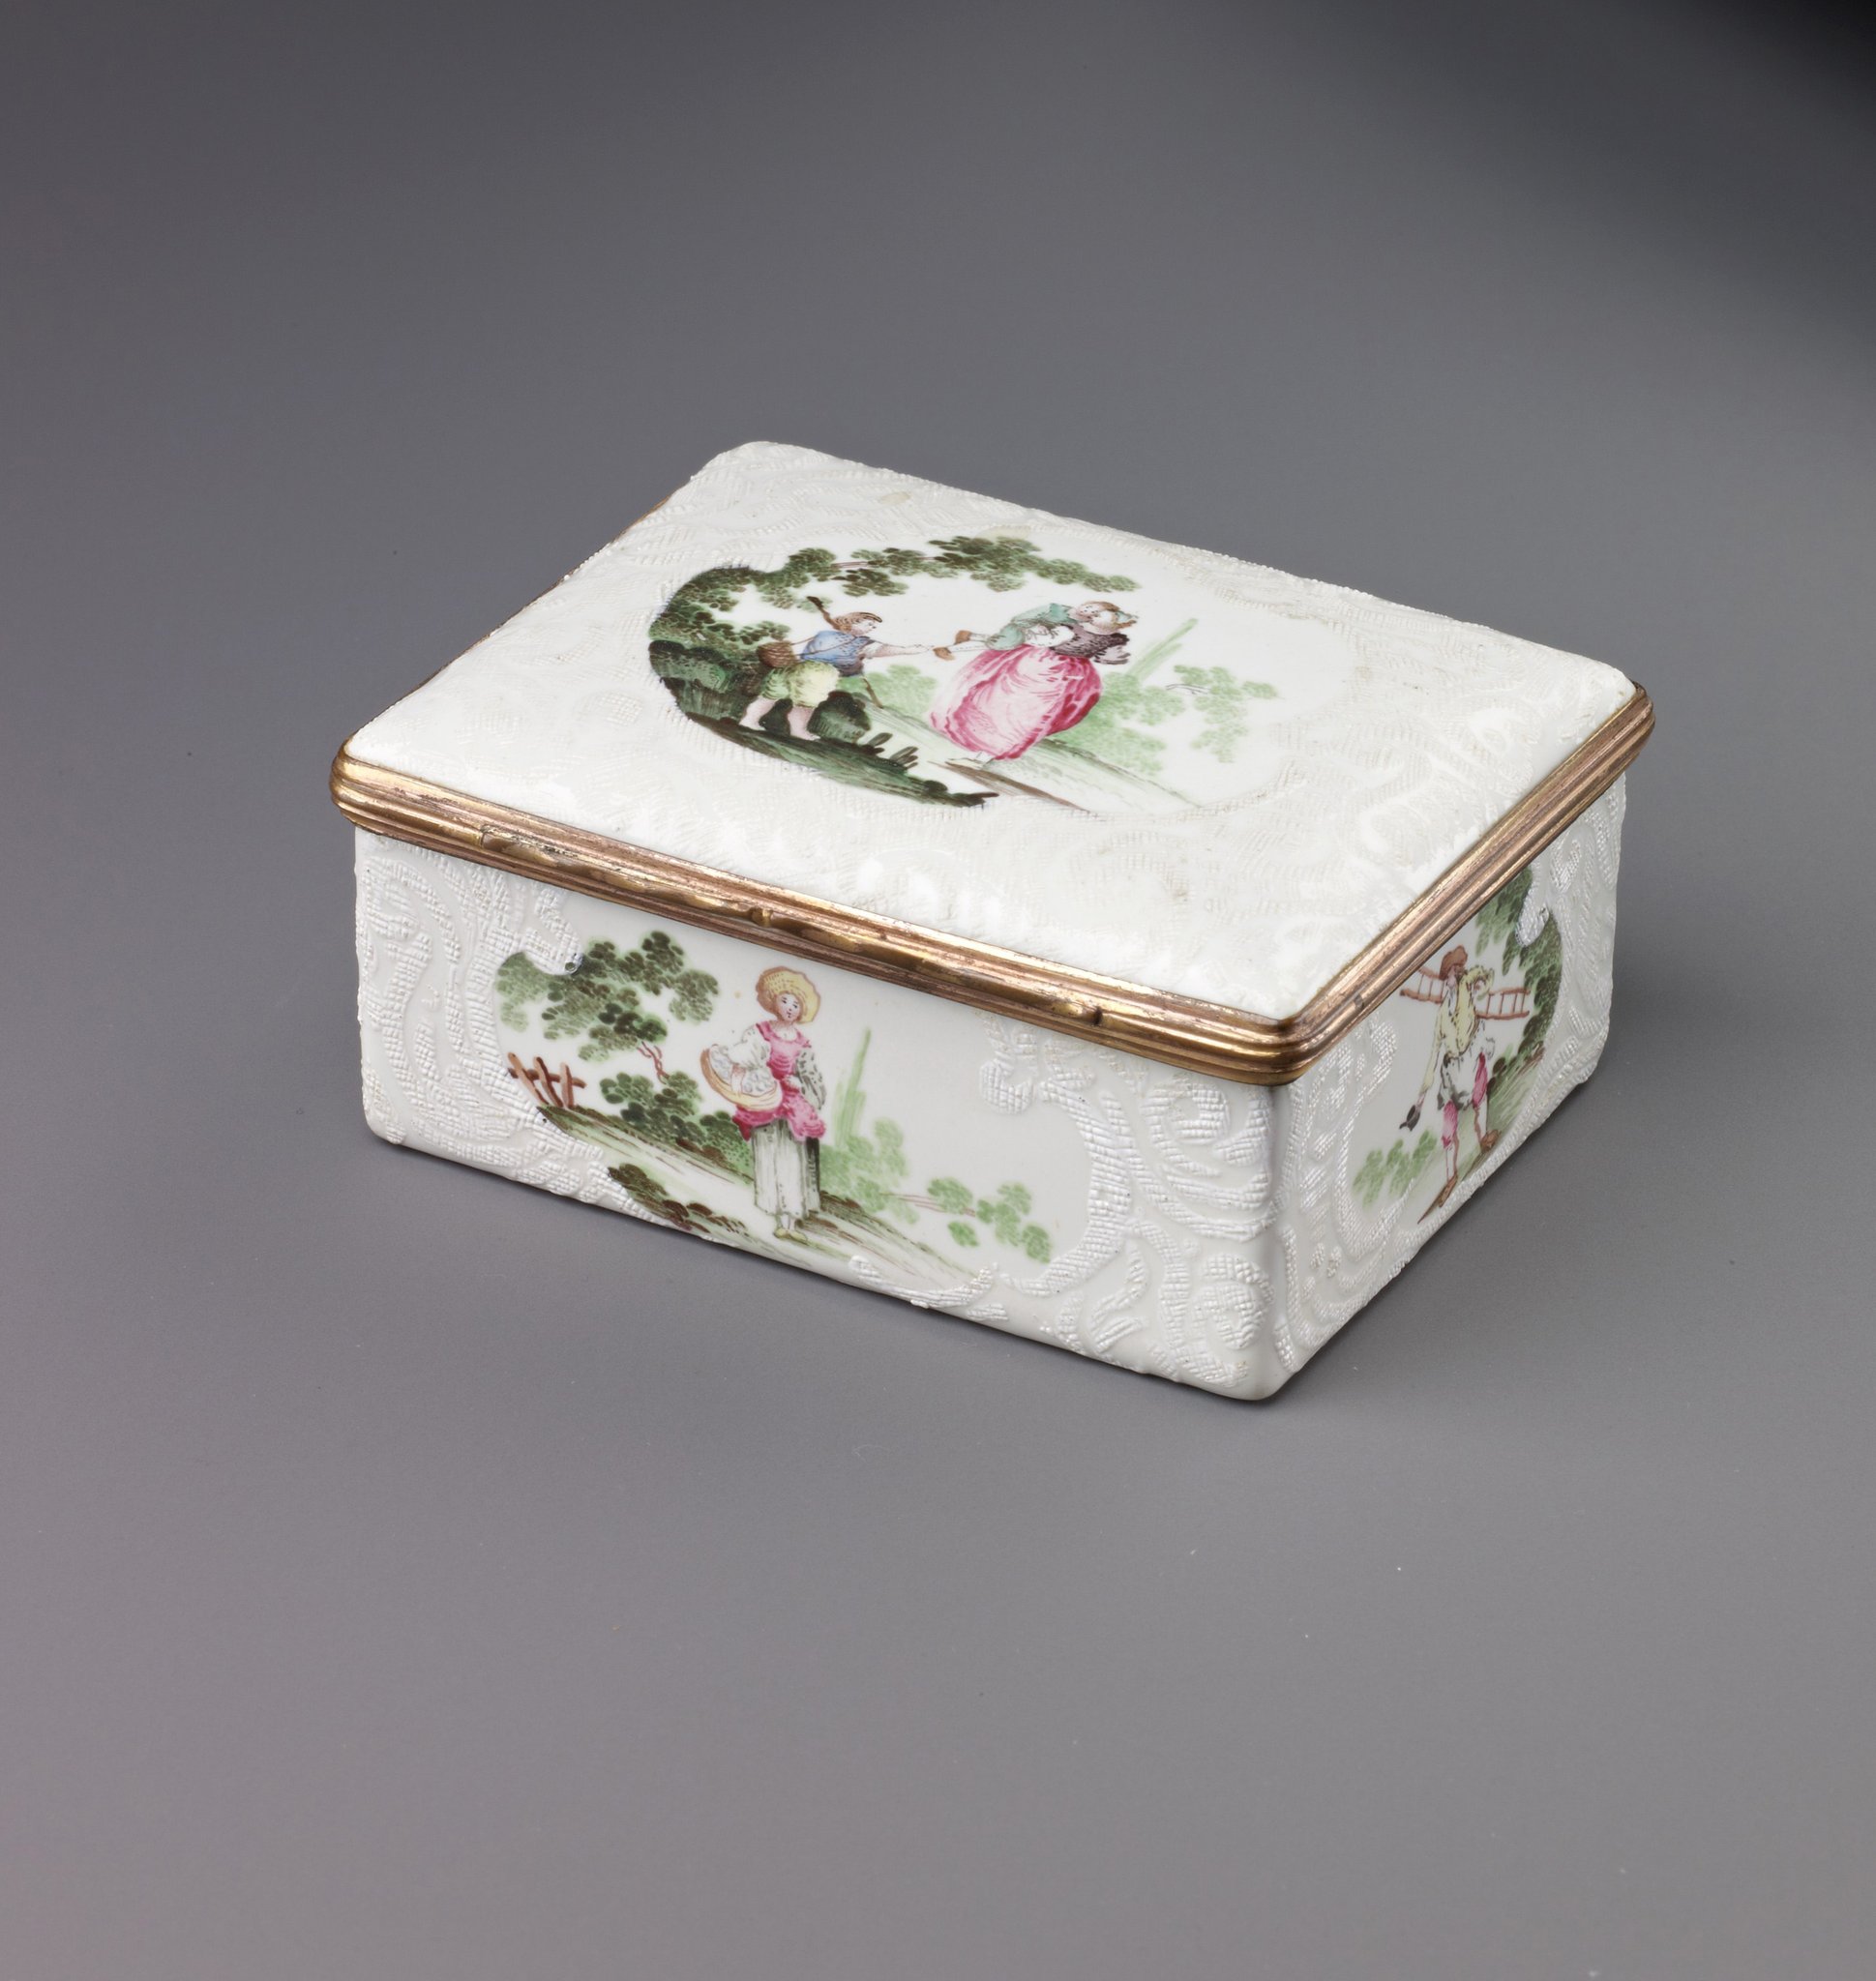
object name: snuffbox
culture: german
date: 1750-1760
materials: copper, gilt copper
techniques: enamel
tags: boys,women